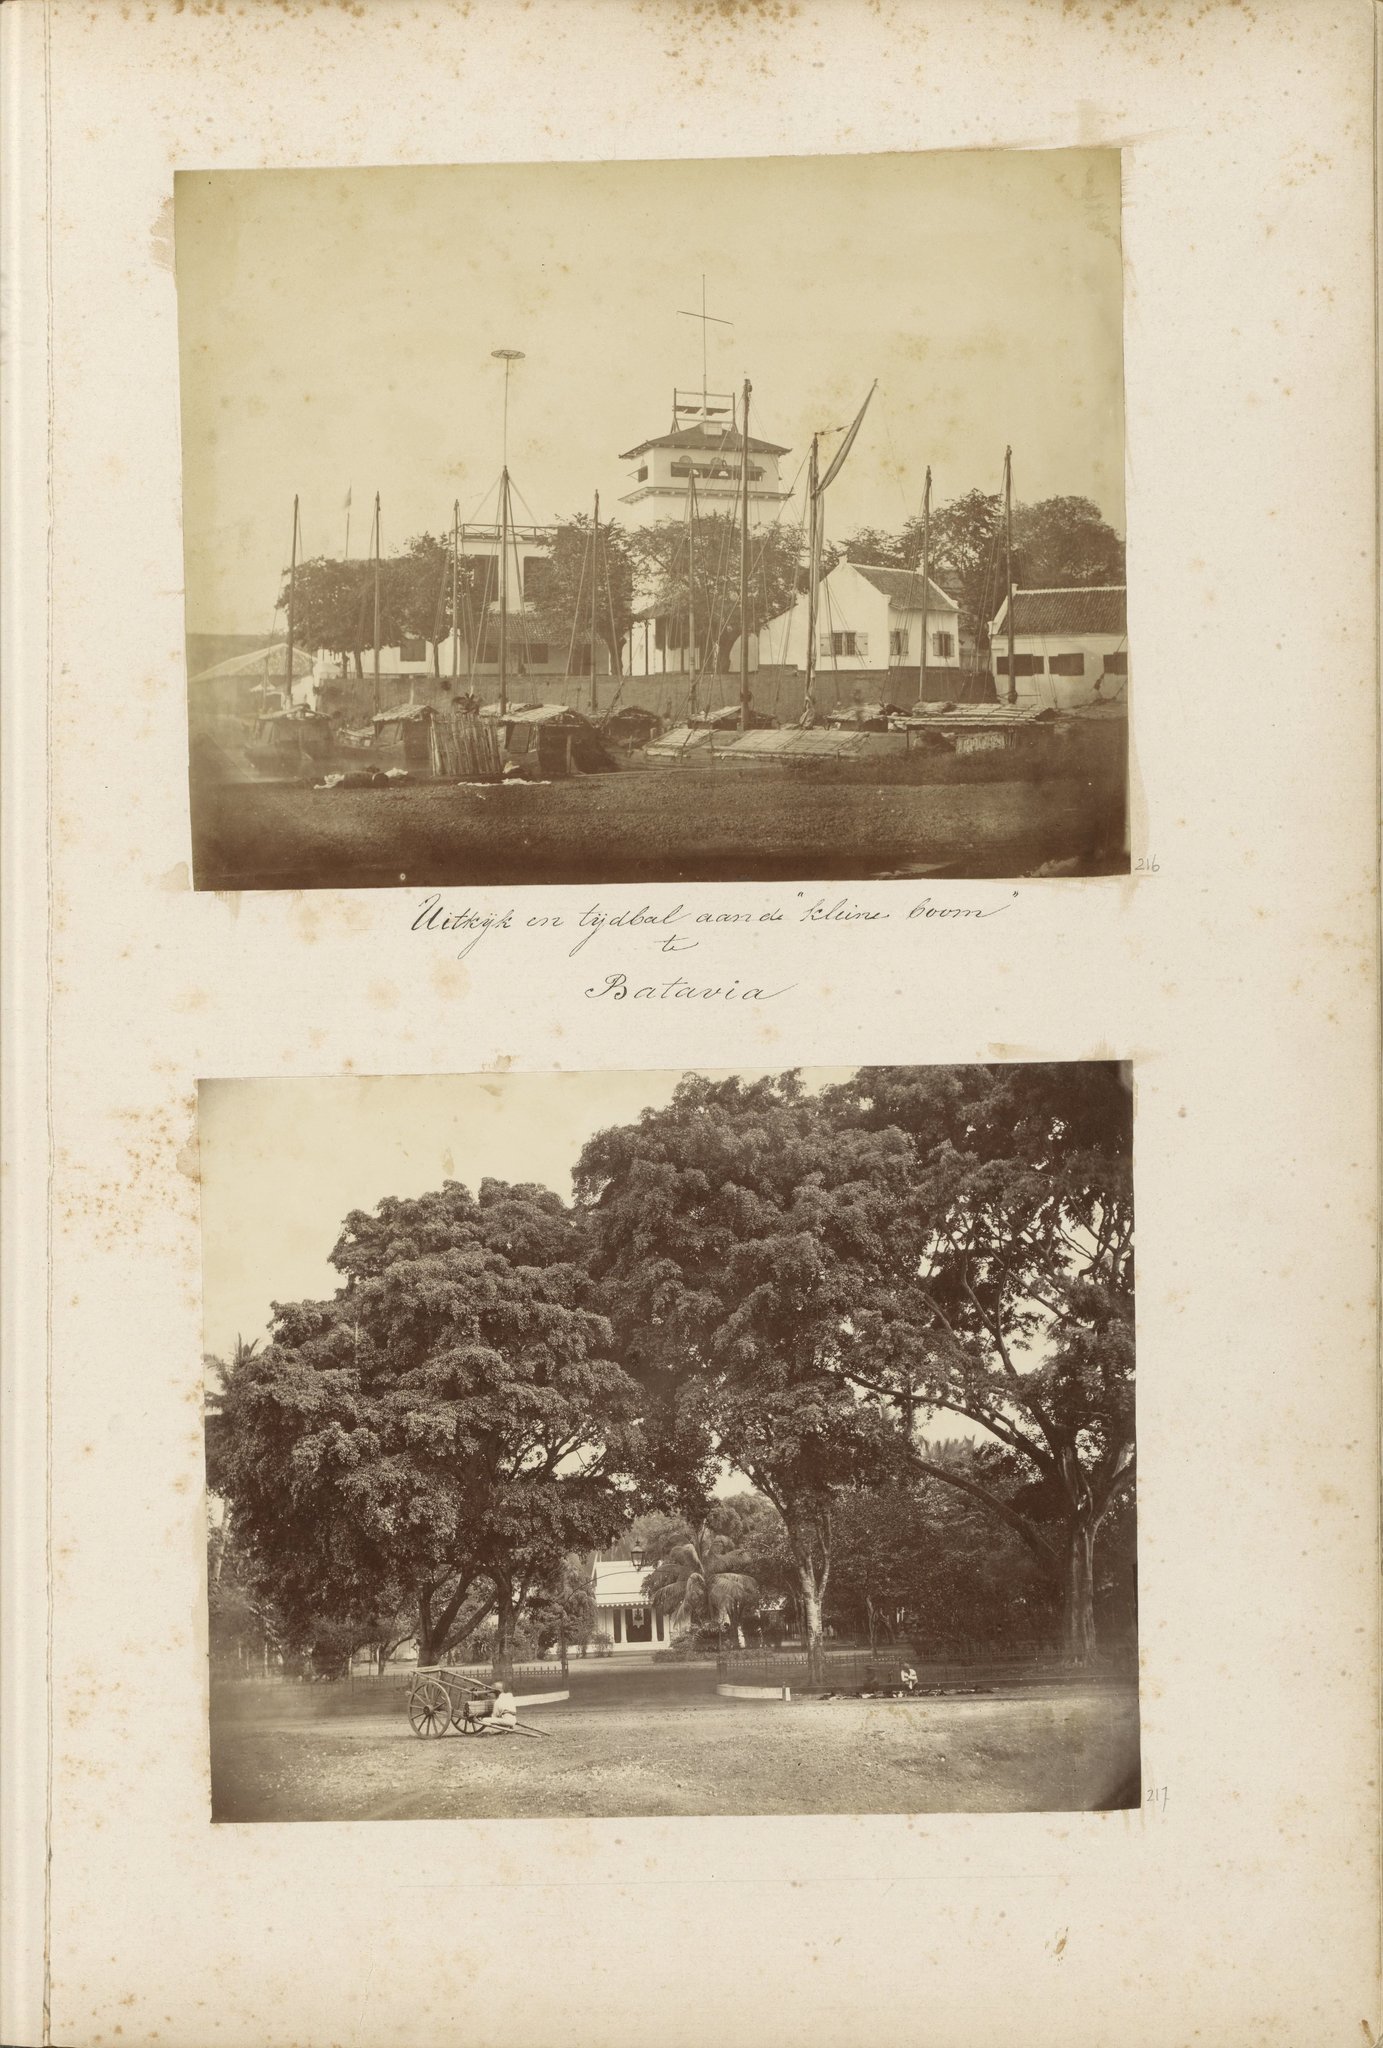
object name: album leaf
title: Aanlegplaats Kleine Boom te Batavia met schepen, uitkijkpost en getijbal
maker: Anonymous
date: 1870-1880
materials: paper, photographic support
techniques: albumen print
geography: batavia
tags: harbour (+ view ~ vehicle, ship, etc.), visual signalling, batavia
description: Onderdeel van Fotoalbum van Robert Daniel Crommelin (1841-1907).